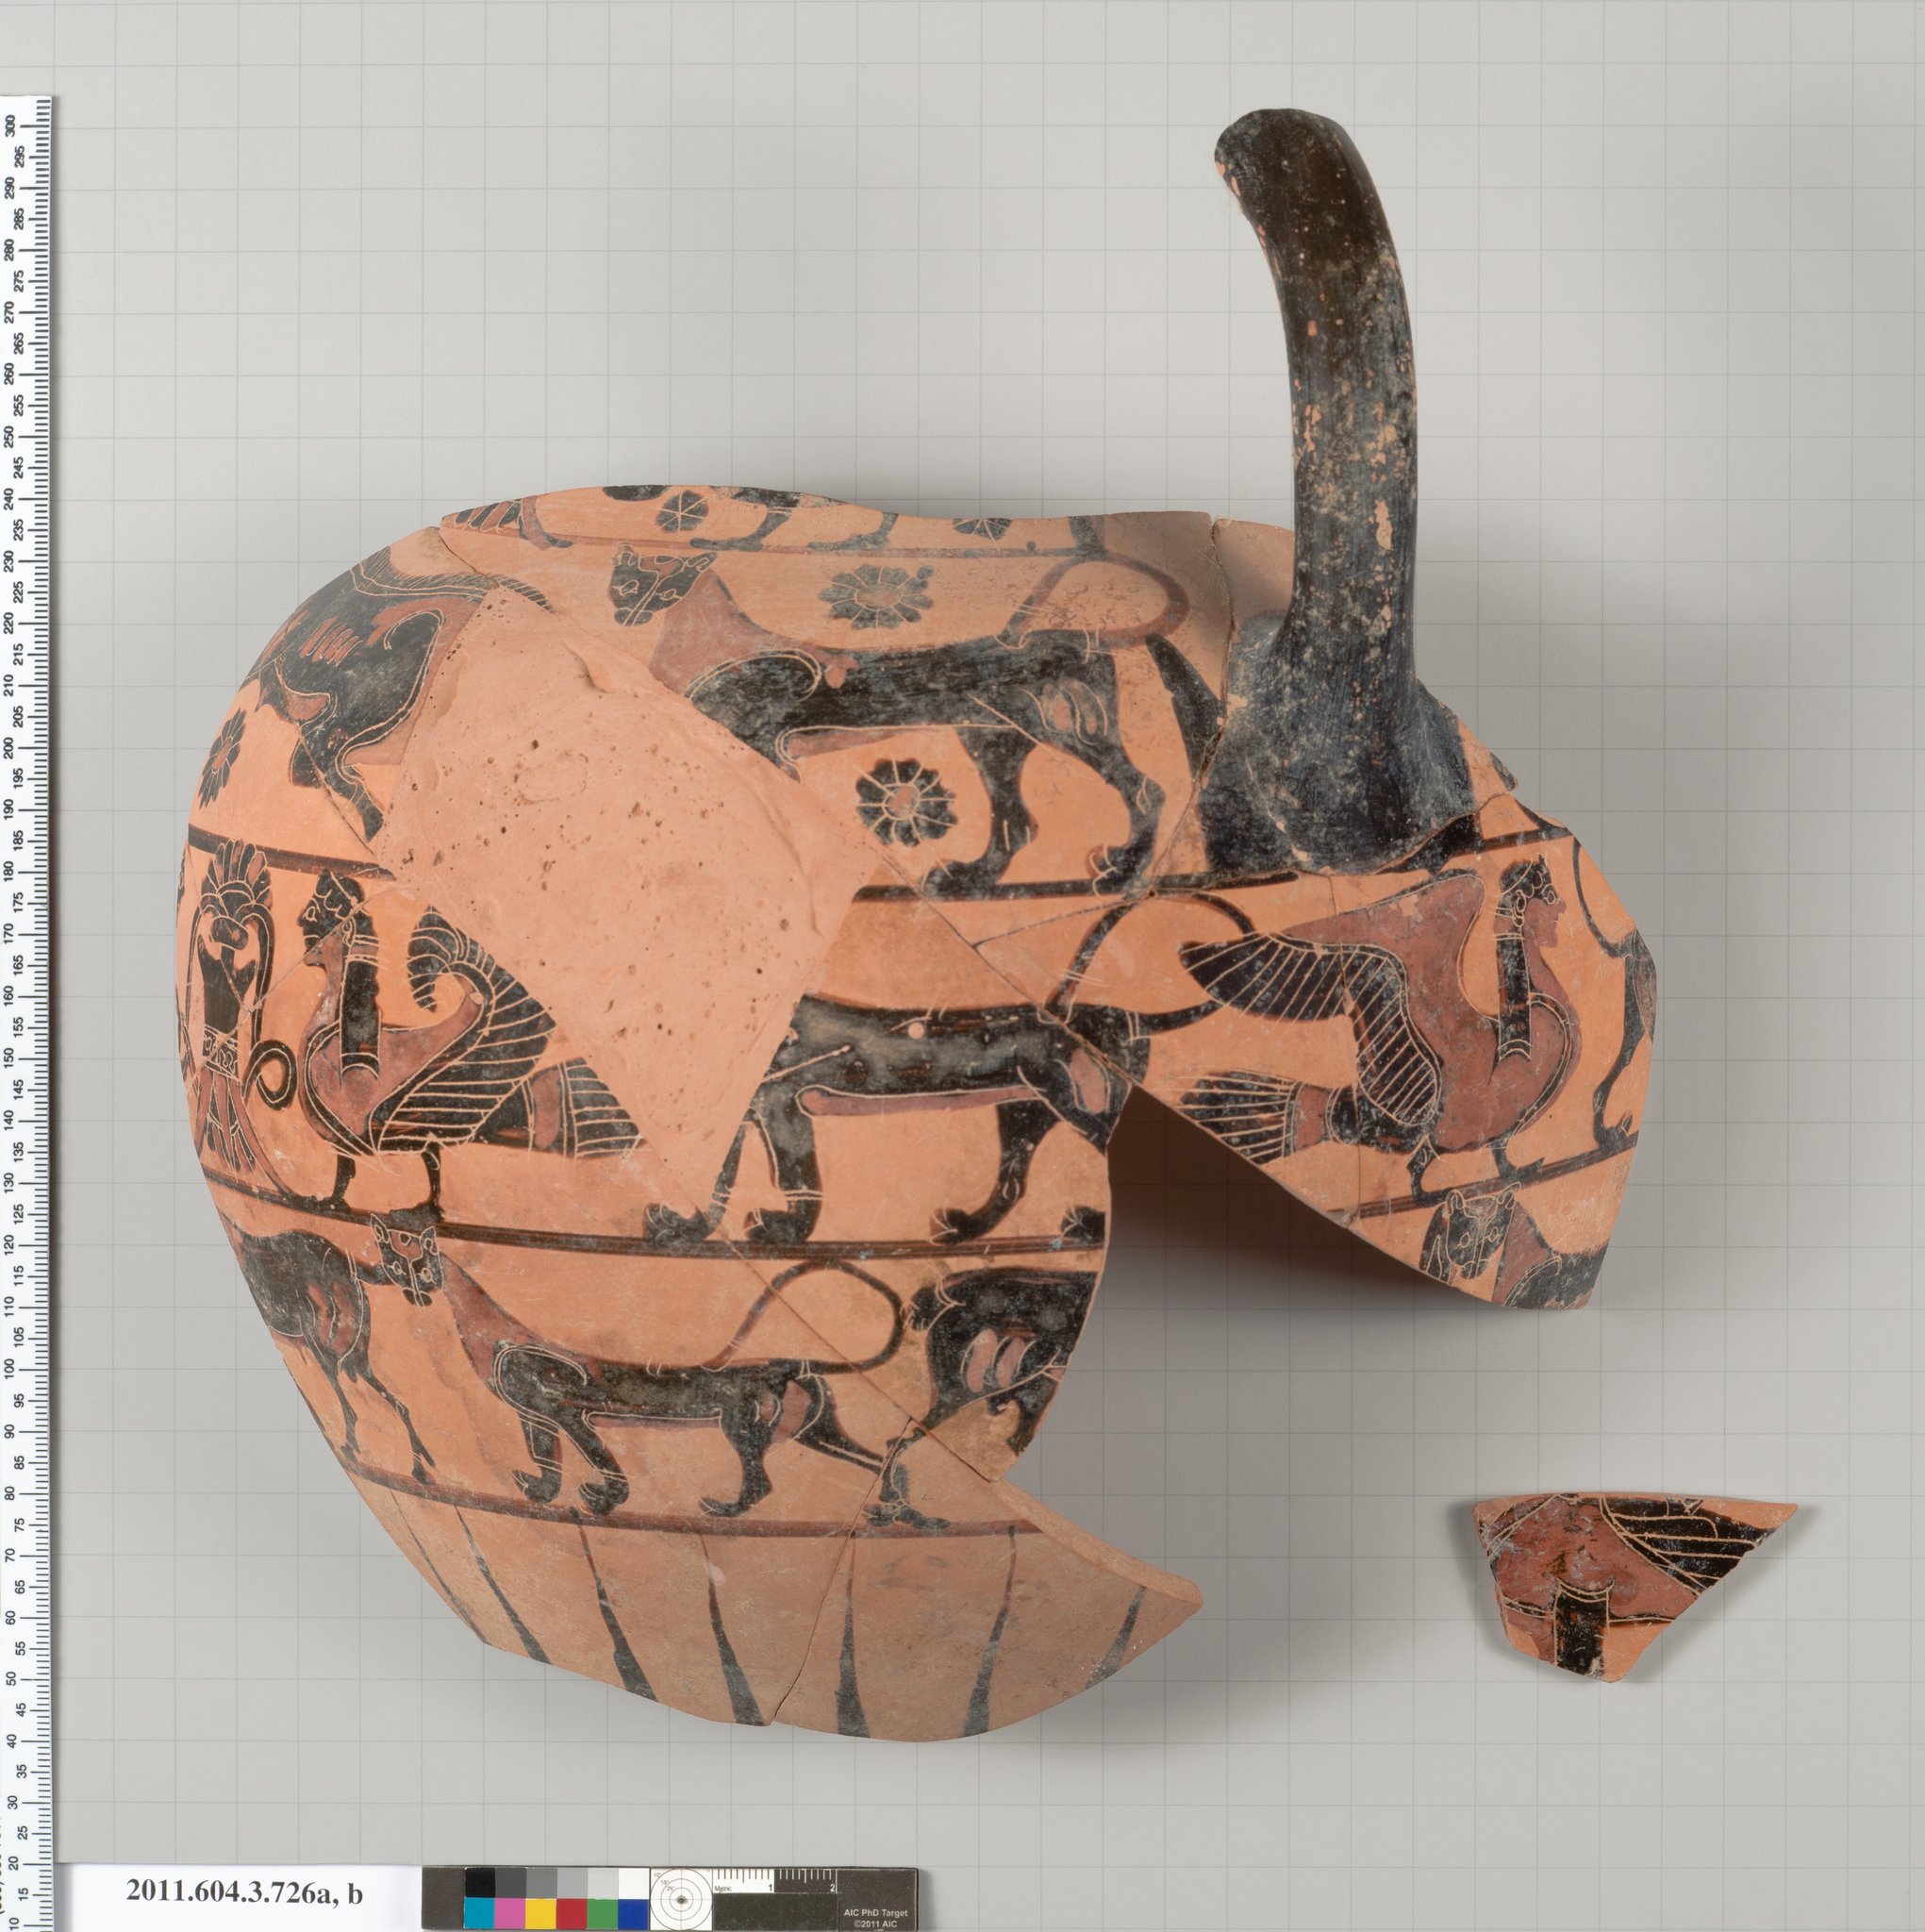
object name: neck amphora, tyrrhenian fragment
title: Terracotta fragments of a neck-amphora (jar)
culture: greek, attic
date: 570 BCE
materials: terracotta